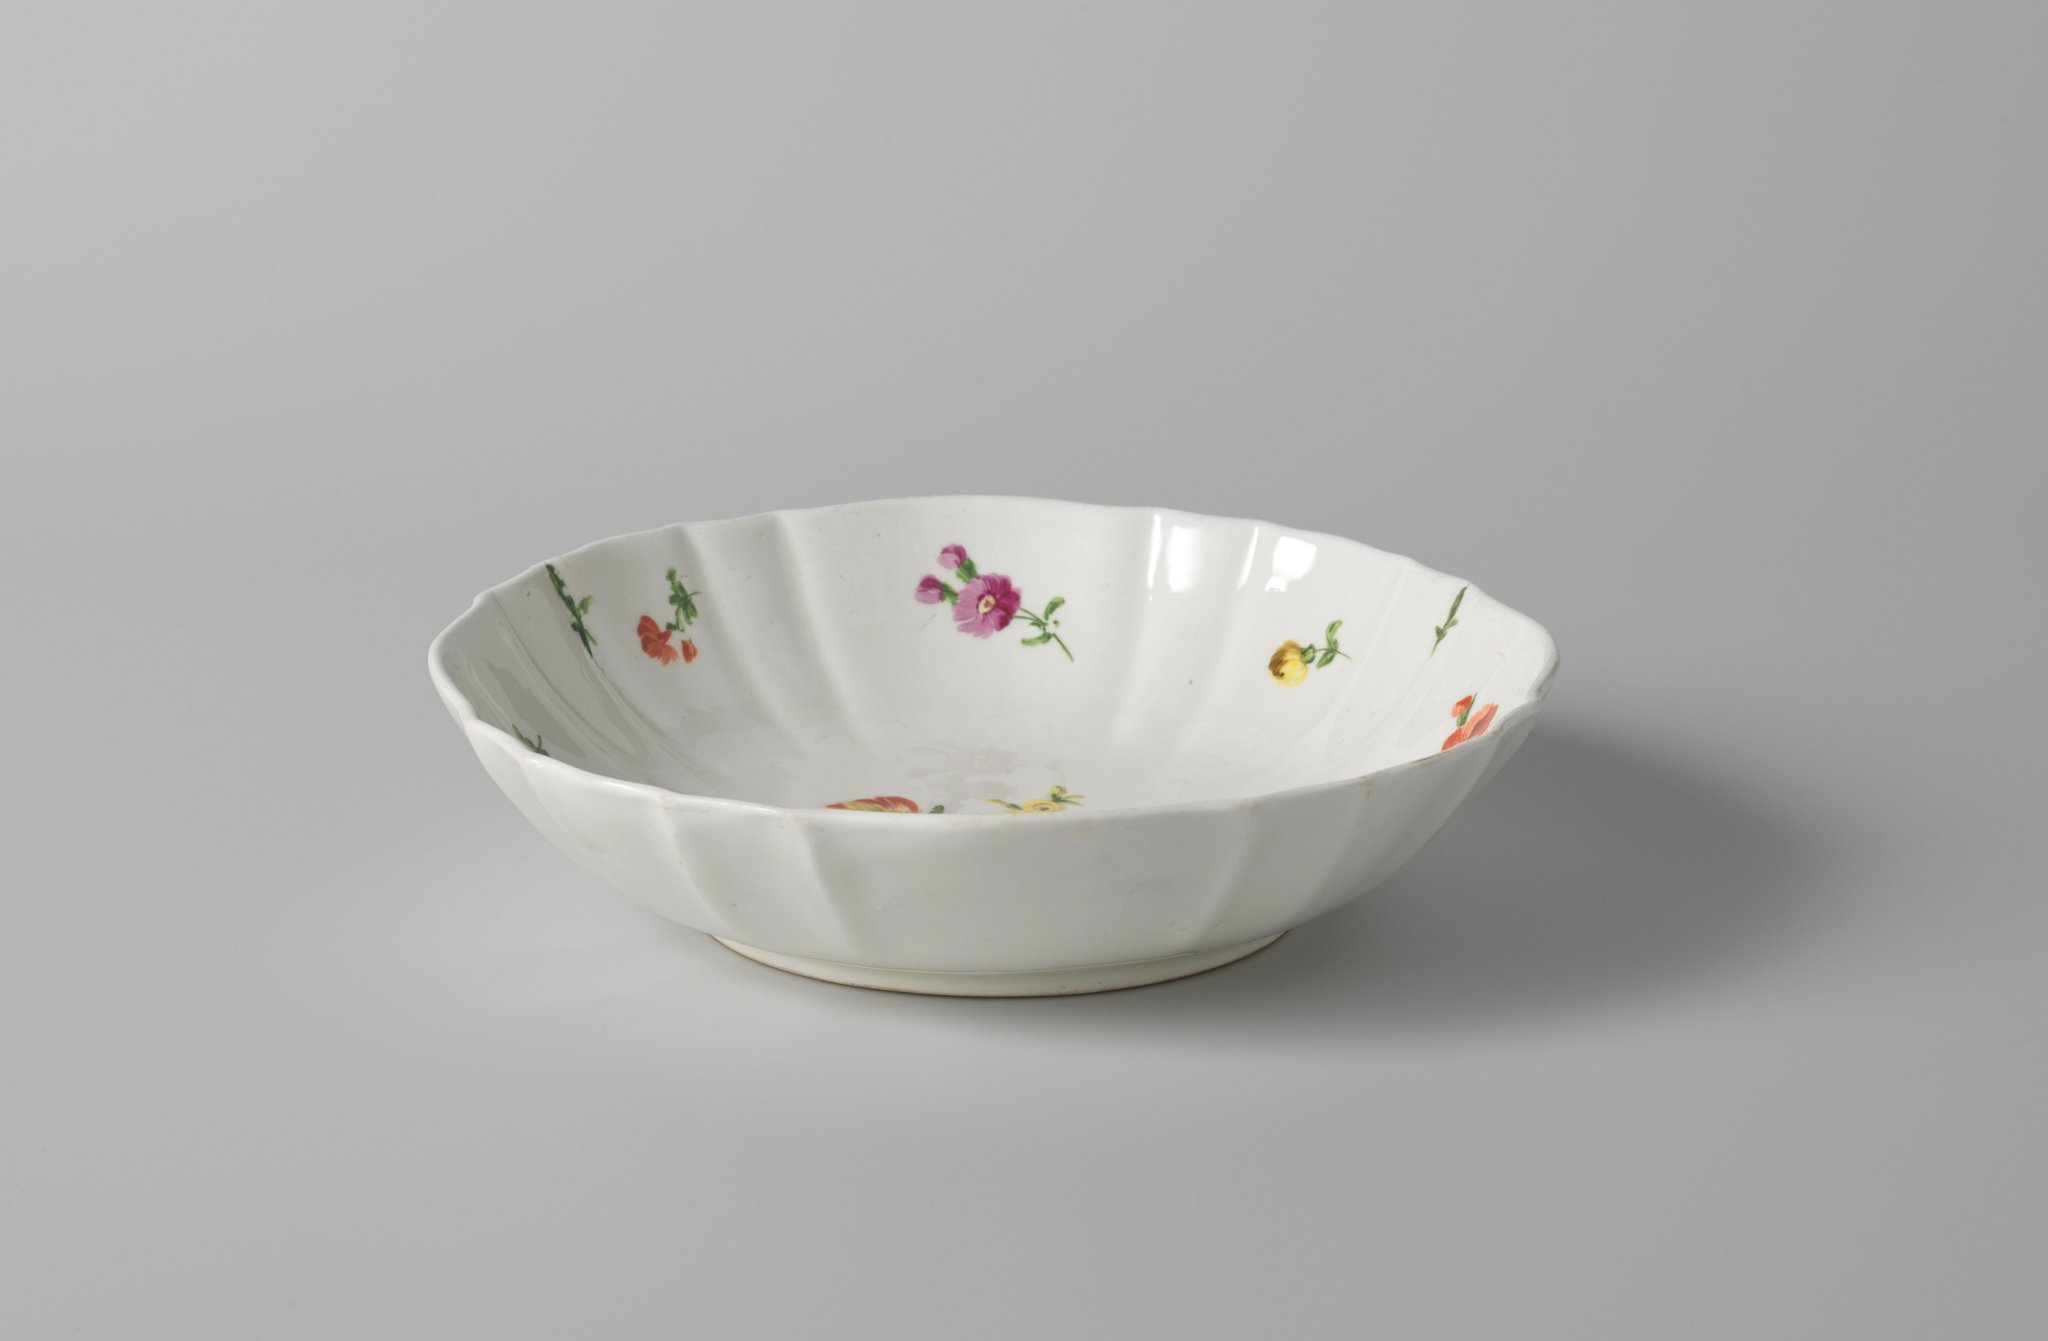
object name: dish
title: Dish with a bouquet and flower sprays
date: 1800-1849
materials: glaze, paint, porcelain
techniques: firing, forming, turning, vitrification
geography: vienna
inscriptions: mark: ‘schild’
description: Schaal van porselein met geschulpte wand en rand, beschilderd op het glazuur in rood, roze, groen en geel. Op het plat een boeket van verschillende bloemen (o.a. pioenroos) en op de binnenwand acht bloemtakken. Gemerkt op de onderzijde met het schild.